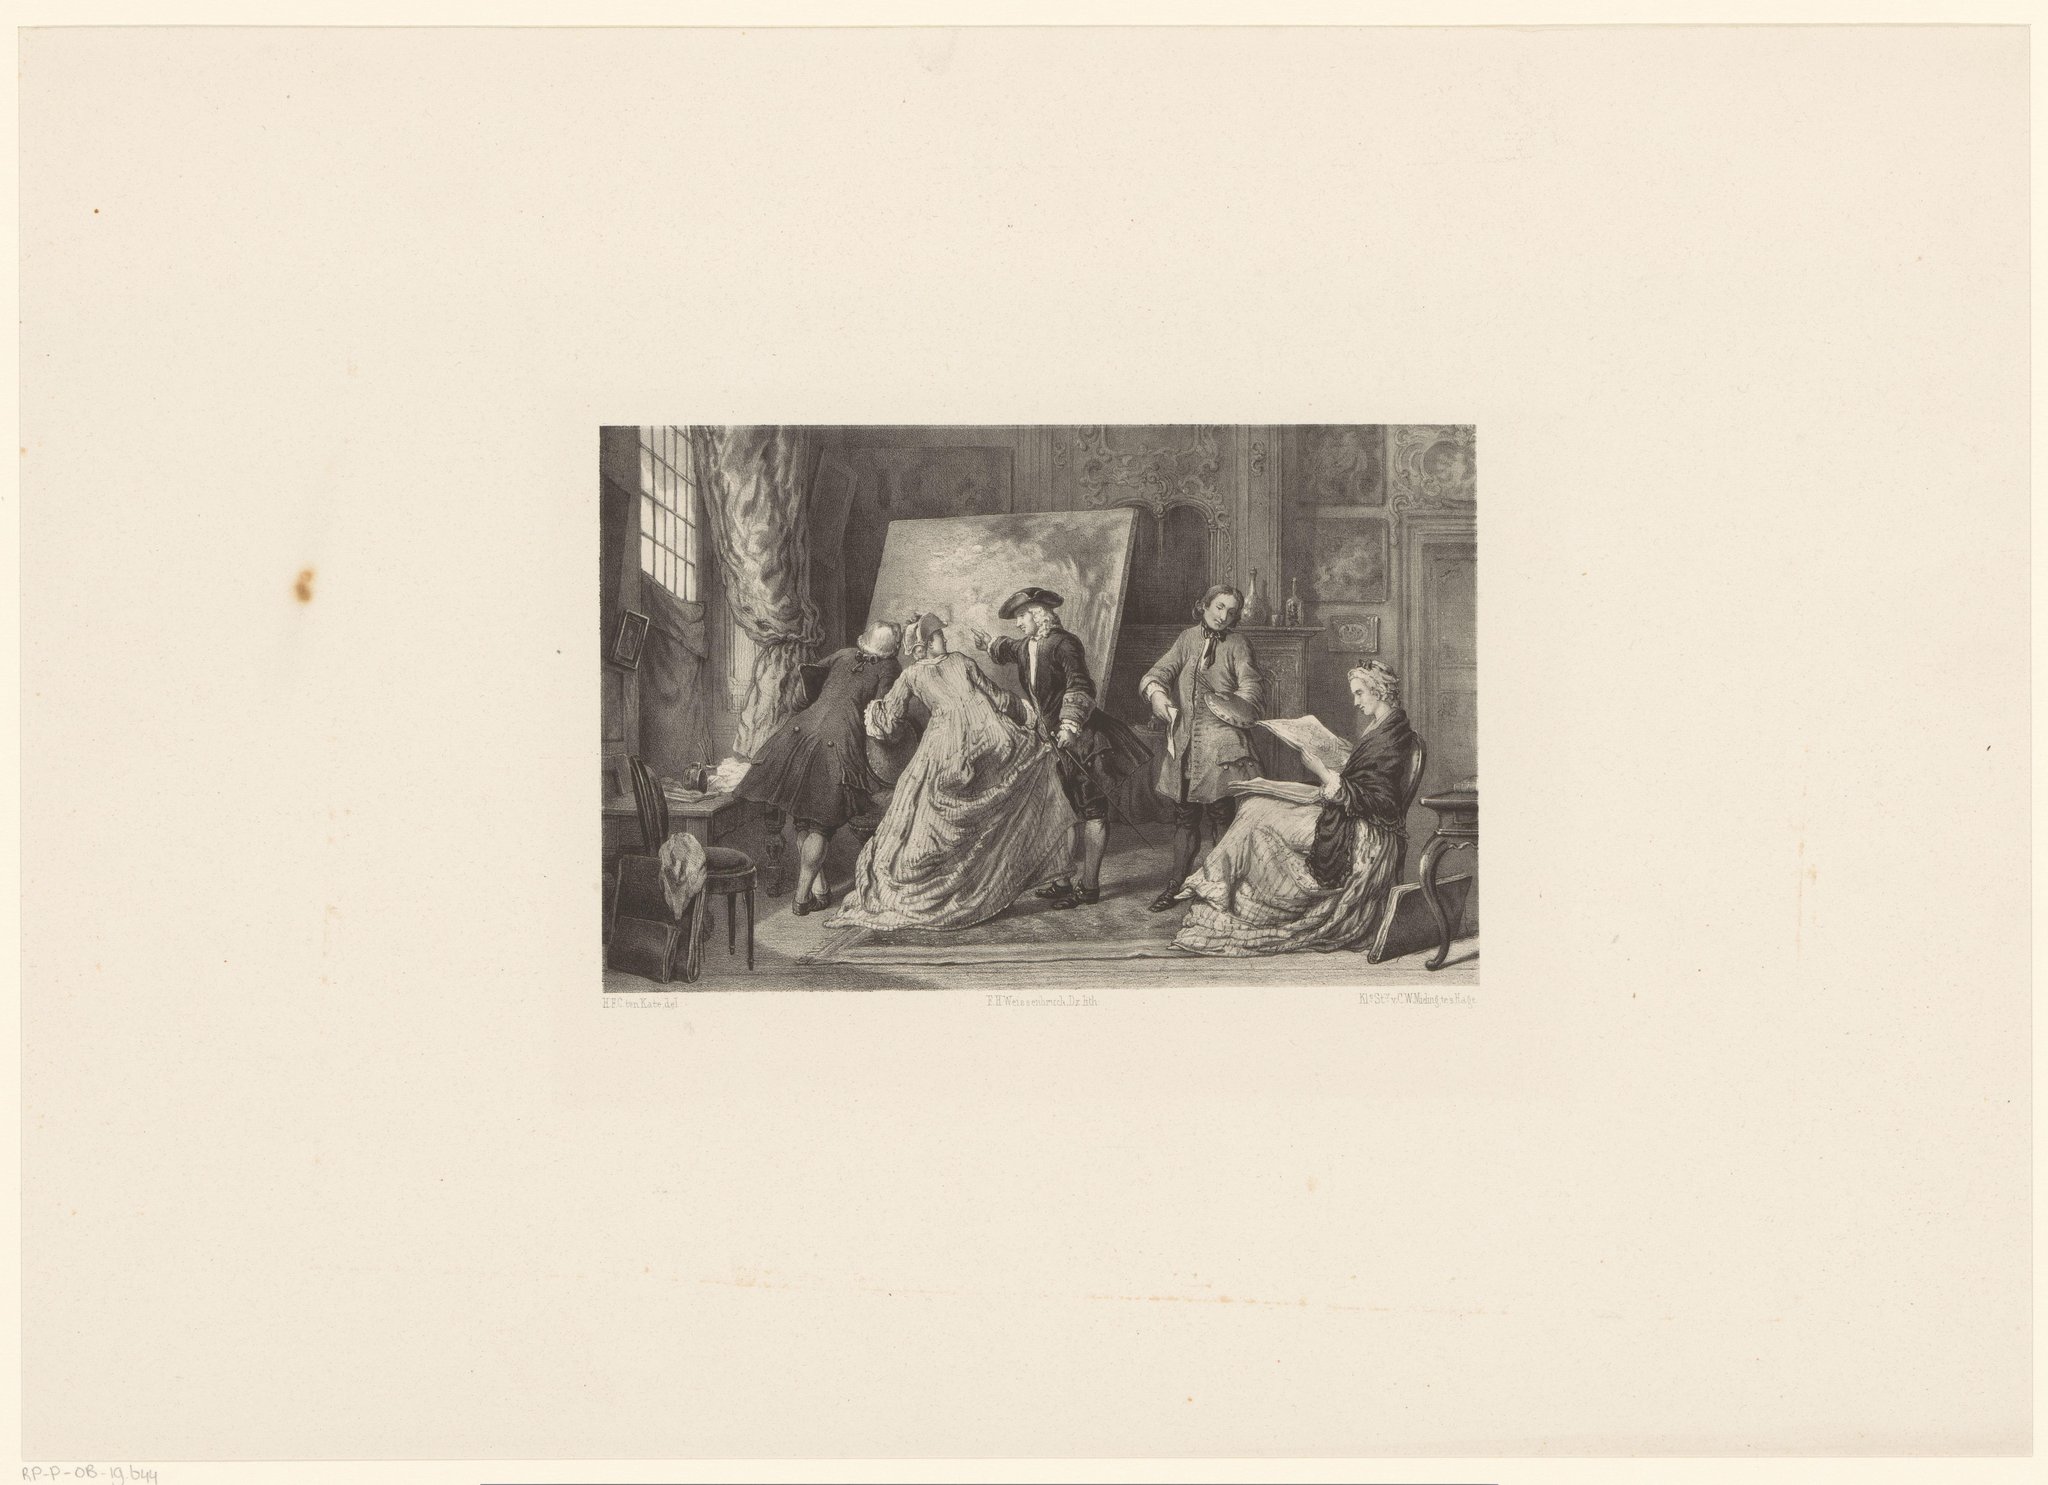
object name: print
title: Gezelschap bewondert een schilderij en tekeningen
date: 1847-1865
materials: paper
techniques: tone lithography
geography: the hague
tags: presenting a work of art to the public; performing, interpreting, reciting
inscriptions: collector's mark: Lugt 2228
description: In een interieur wijst een man met stok een paar op een schilderij. Naast hem staat een jongeman met schilderspalet. Rechts bekijkt een zittende vrouw een stapel tekeningen.